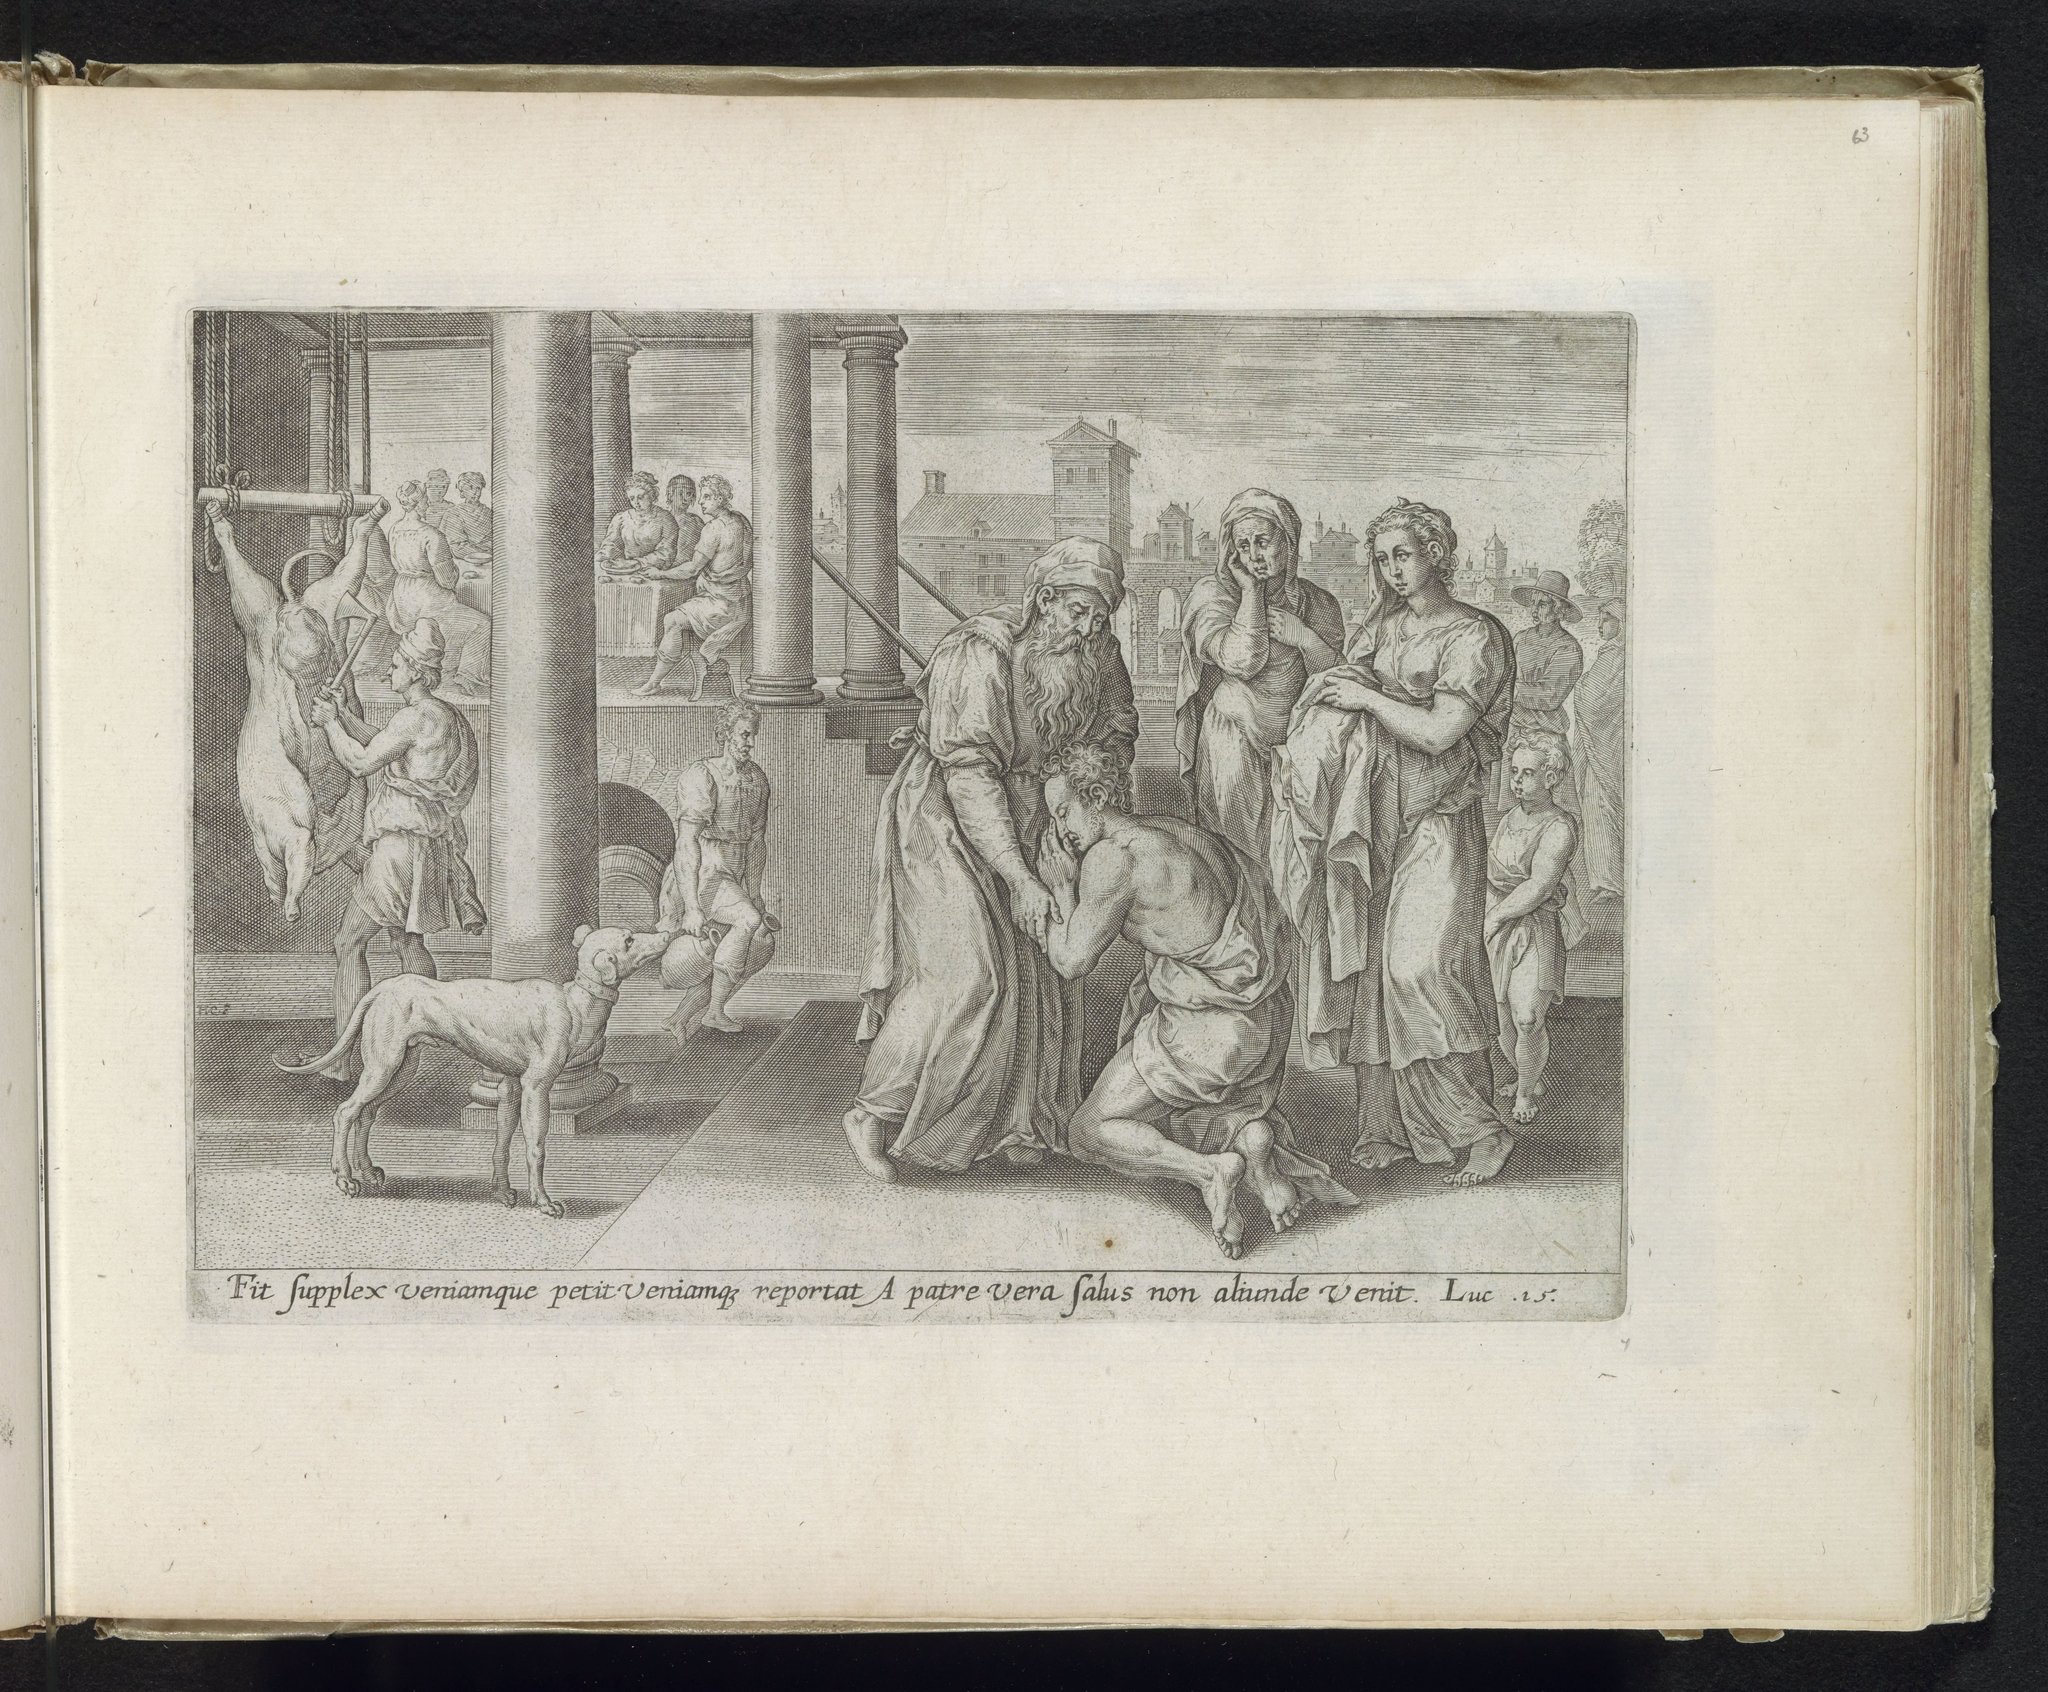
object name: album leaf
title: Terugkeer van de verloren zoon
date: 1585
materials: paper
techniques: engraving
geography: antwerp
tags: the prodigal son kneels before his father who takes him in his arms, preparations, e.g. the prodigal son is given new robes; slaughtering of the fatted calf; the elder son objects, festive reception of the prodigal son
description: De verloren zoon keert terug naar huis en valt zijn vader in de armen. Links wordt het gemeste kalf geslacht en links op de achtergrond wordt een feestmaal gegeven om de terugkeer van de verloren zoon te vieren. Onder de voorstelling een verwijzing in het Latijn naar de Bijbeltekst in Luc. 15. Deze prent maakt deel uit van een album.